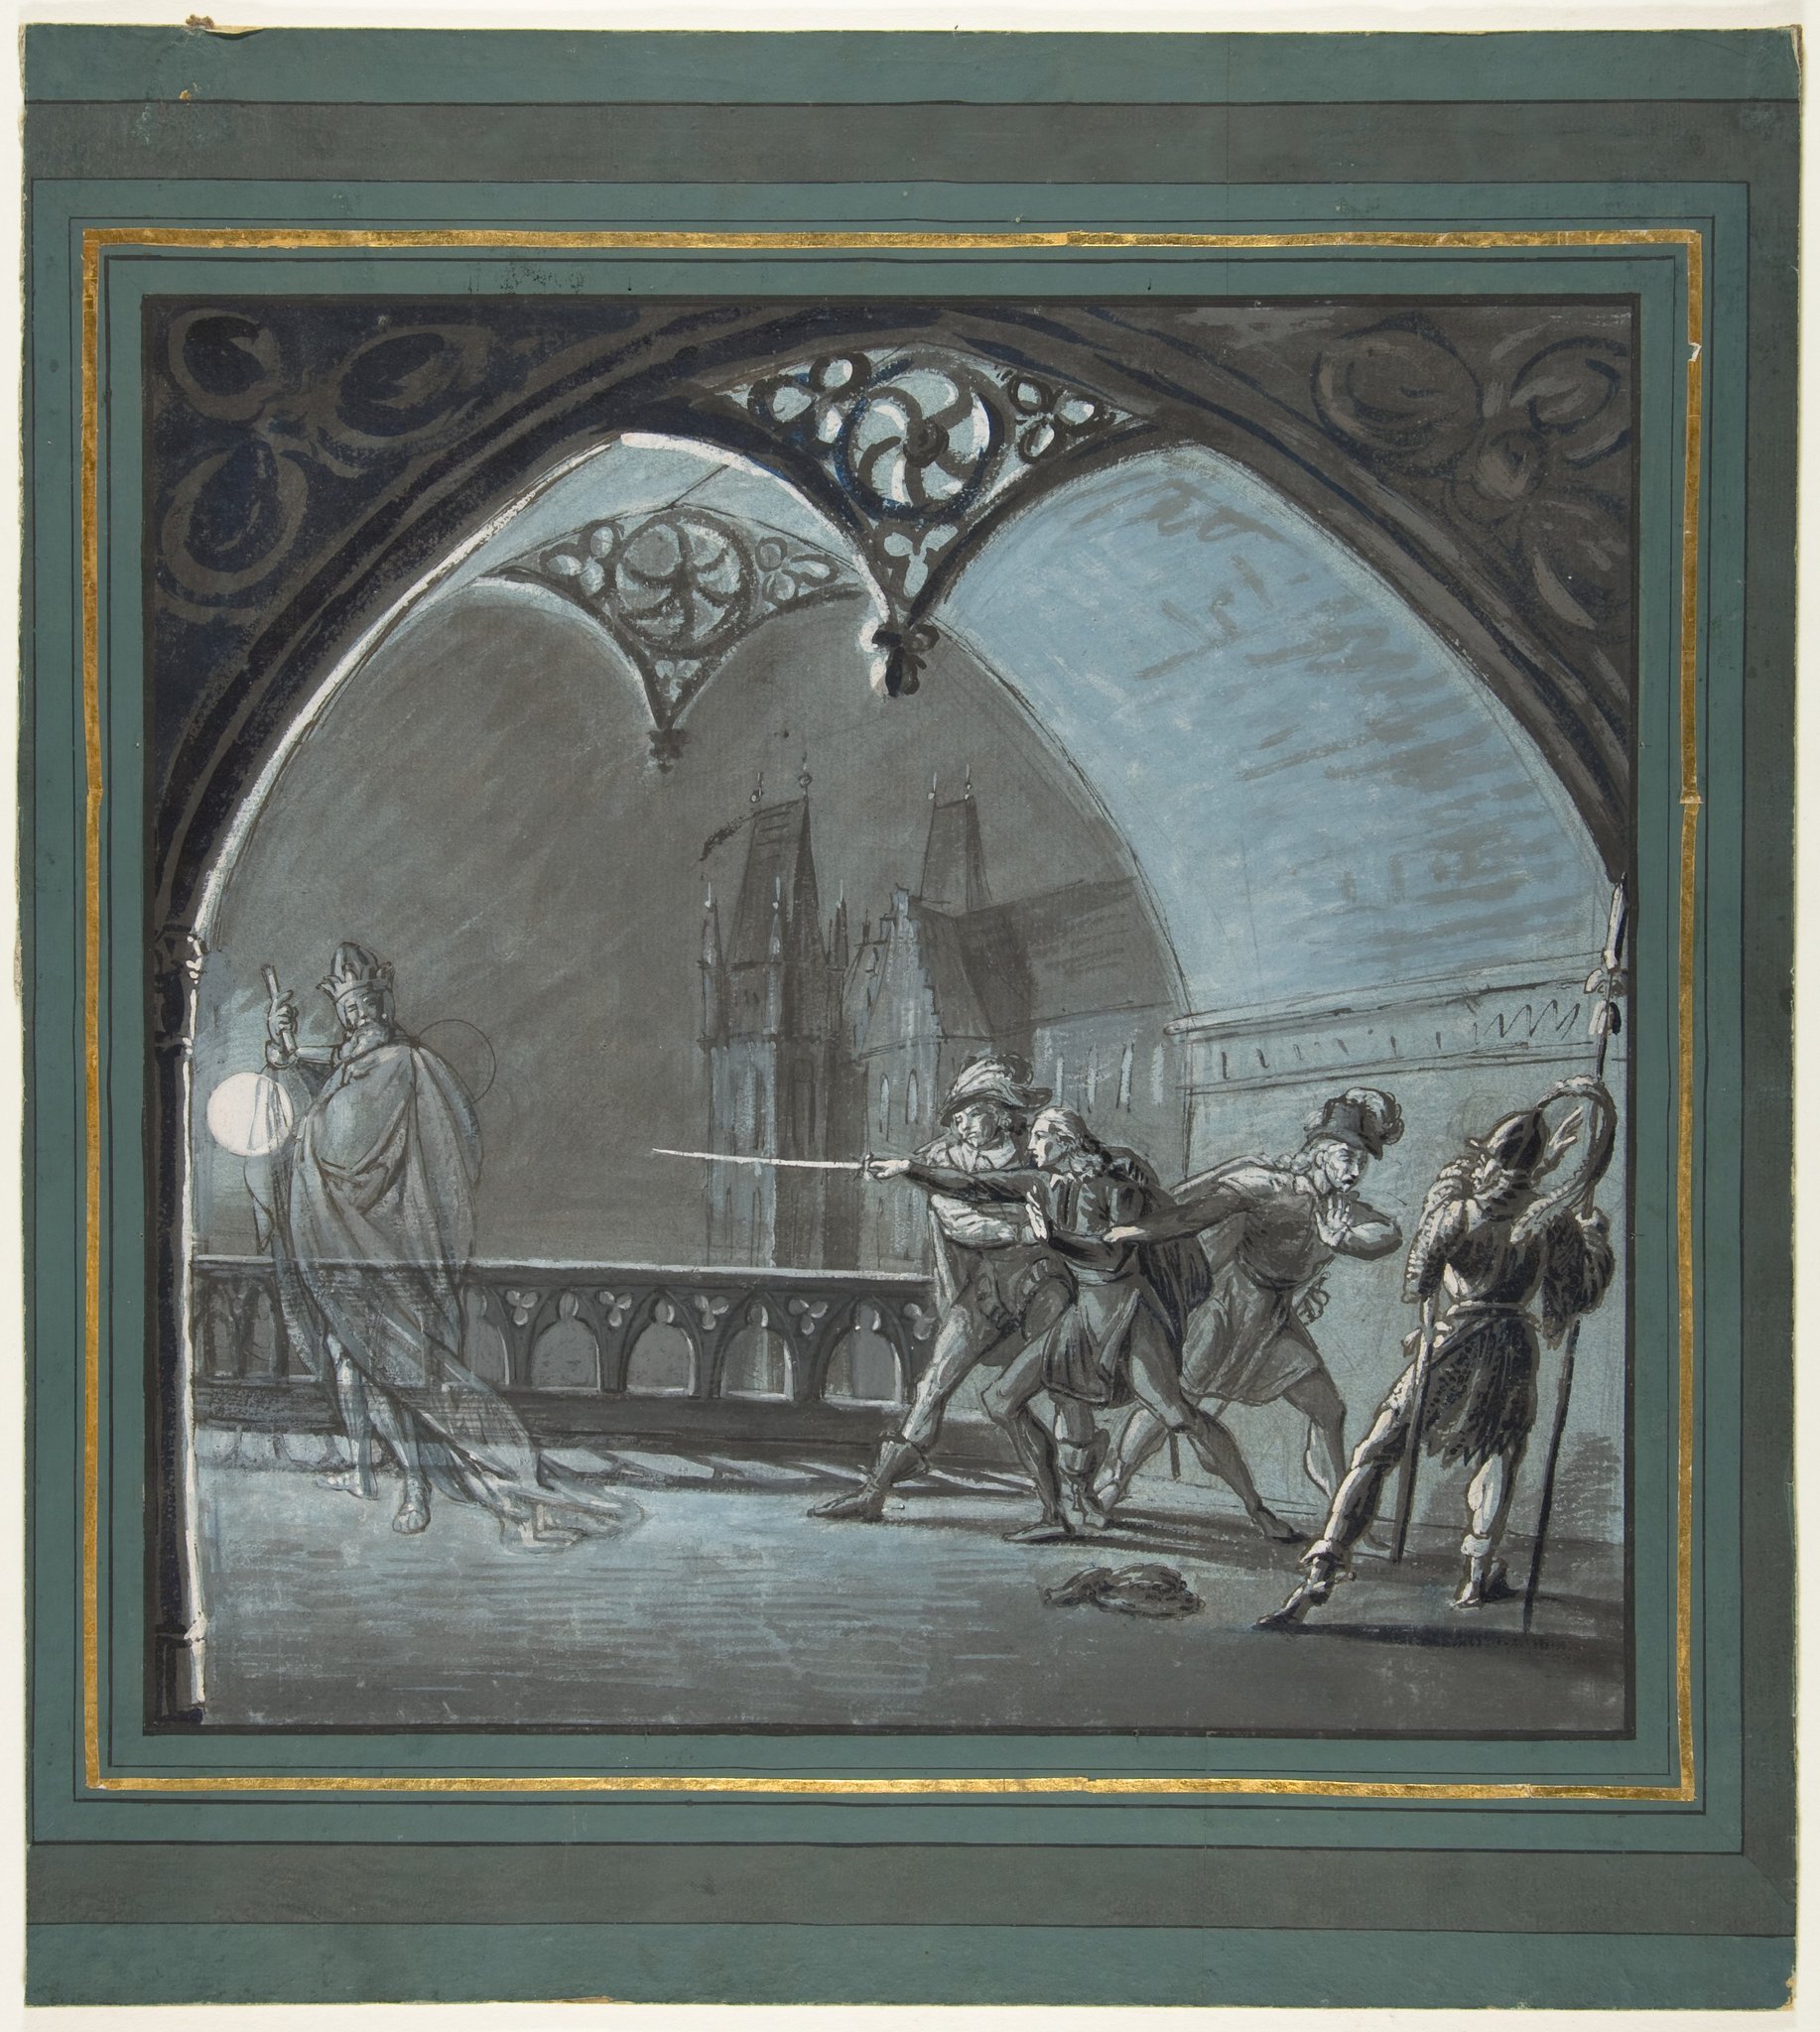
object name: drawing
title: The Ghost of the King Appearing to Hamlet, Horatio and Guards (Hamlet, Act 1, Scene 4)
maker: anonymous, french, 19th century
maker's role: artist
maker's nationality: french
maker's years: 1800-1900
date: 1801-1900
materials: gouache, ink, paper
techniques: brush, pen, wash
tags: shakespeare,men,hamlet